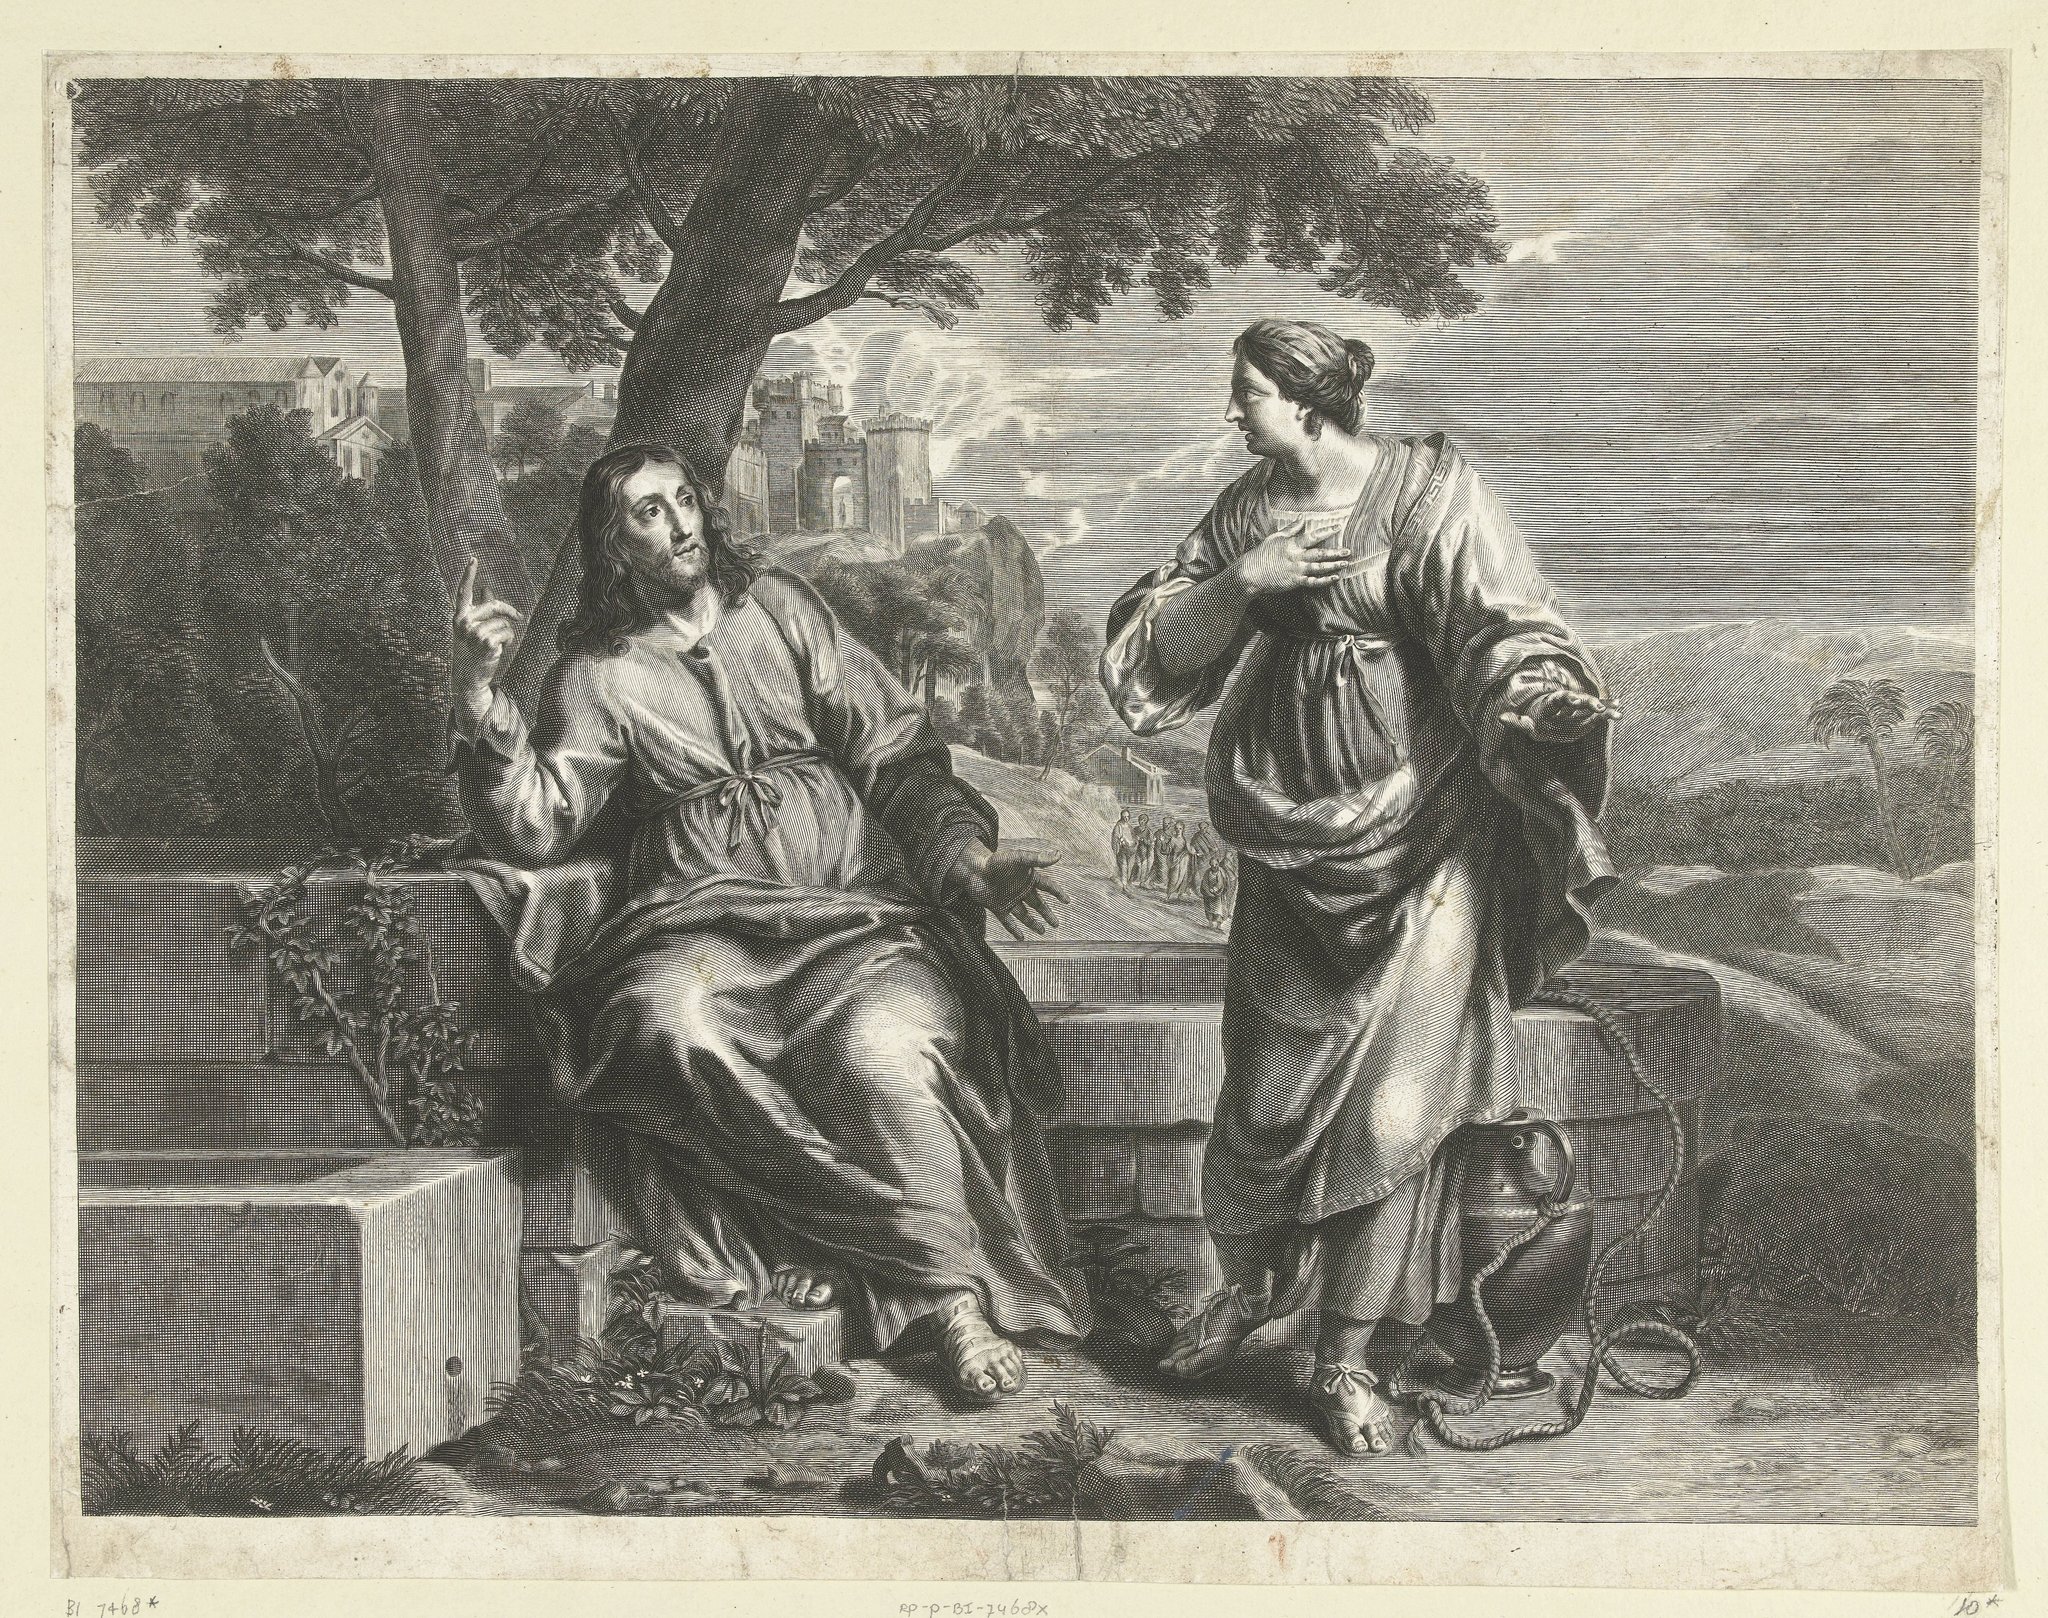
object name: print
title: Christus en de Samaritaanse vrouw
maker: Anonymous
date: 1670-1757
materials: paper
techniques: engraving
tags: christ and the woman of samaria: sitting at jacob's well he asks her for a drink from her jug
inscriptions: collector's mark: Lugt 240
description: Christus zit op de rand van de waterput en spreekt de Samaritaanse vrouw aan, die bij haar kruik staat. Op de achtergrond een stad. Kopie in spiegelbeeld naar een prent van Gerard Edelinck.